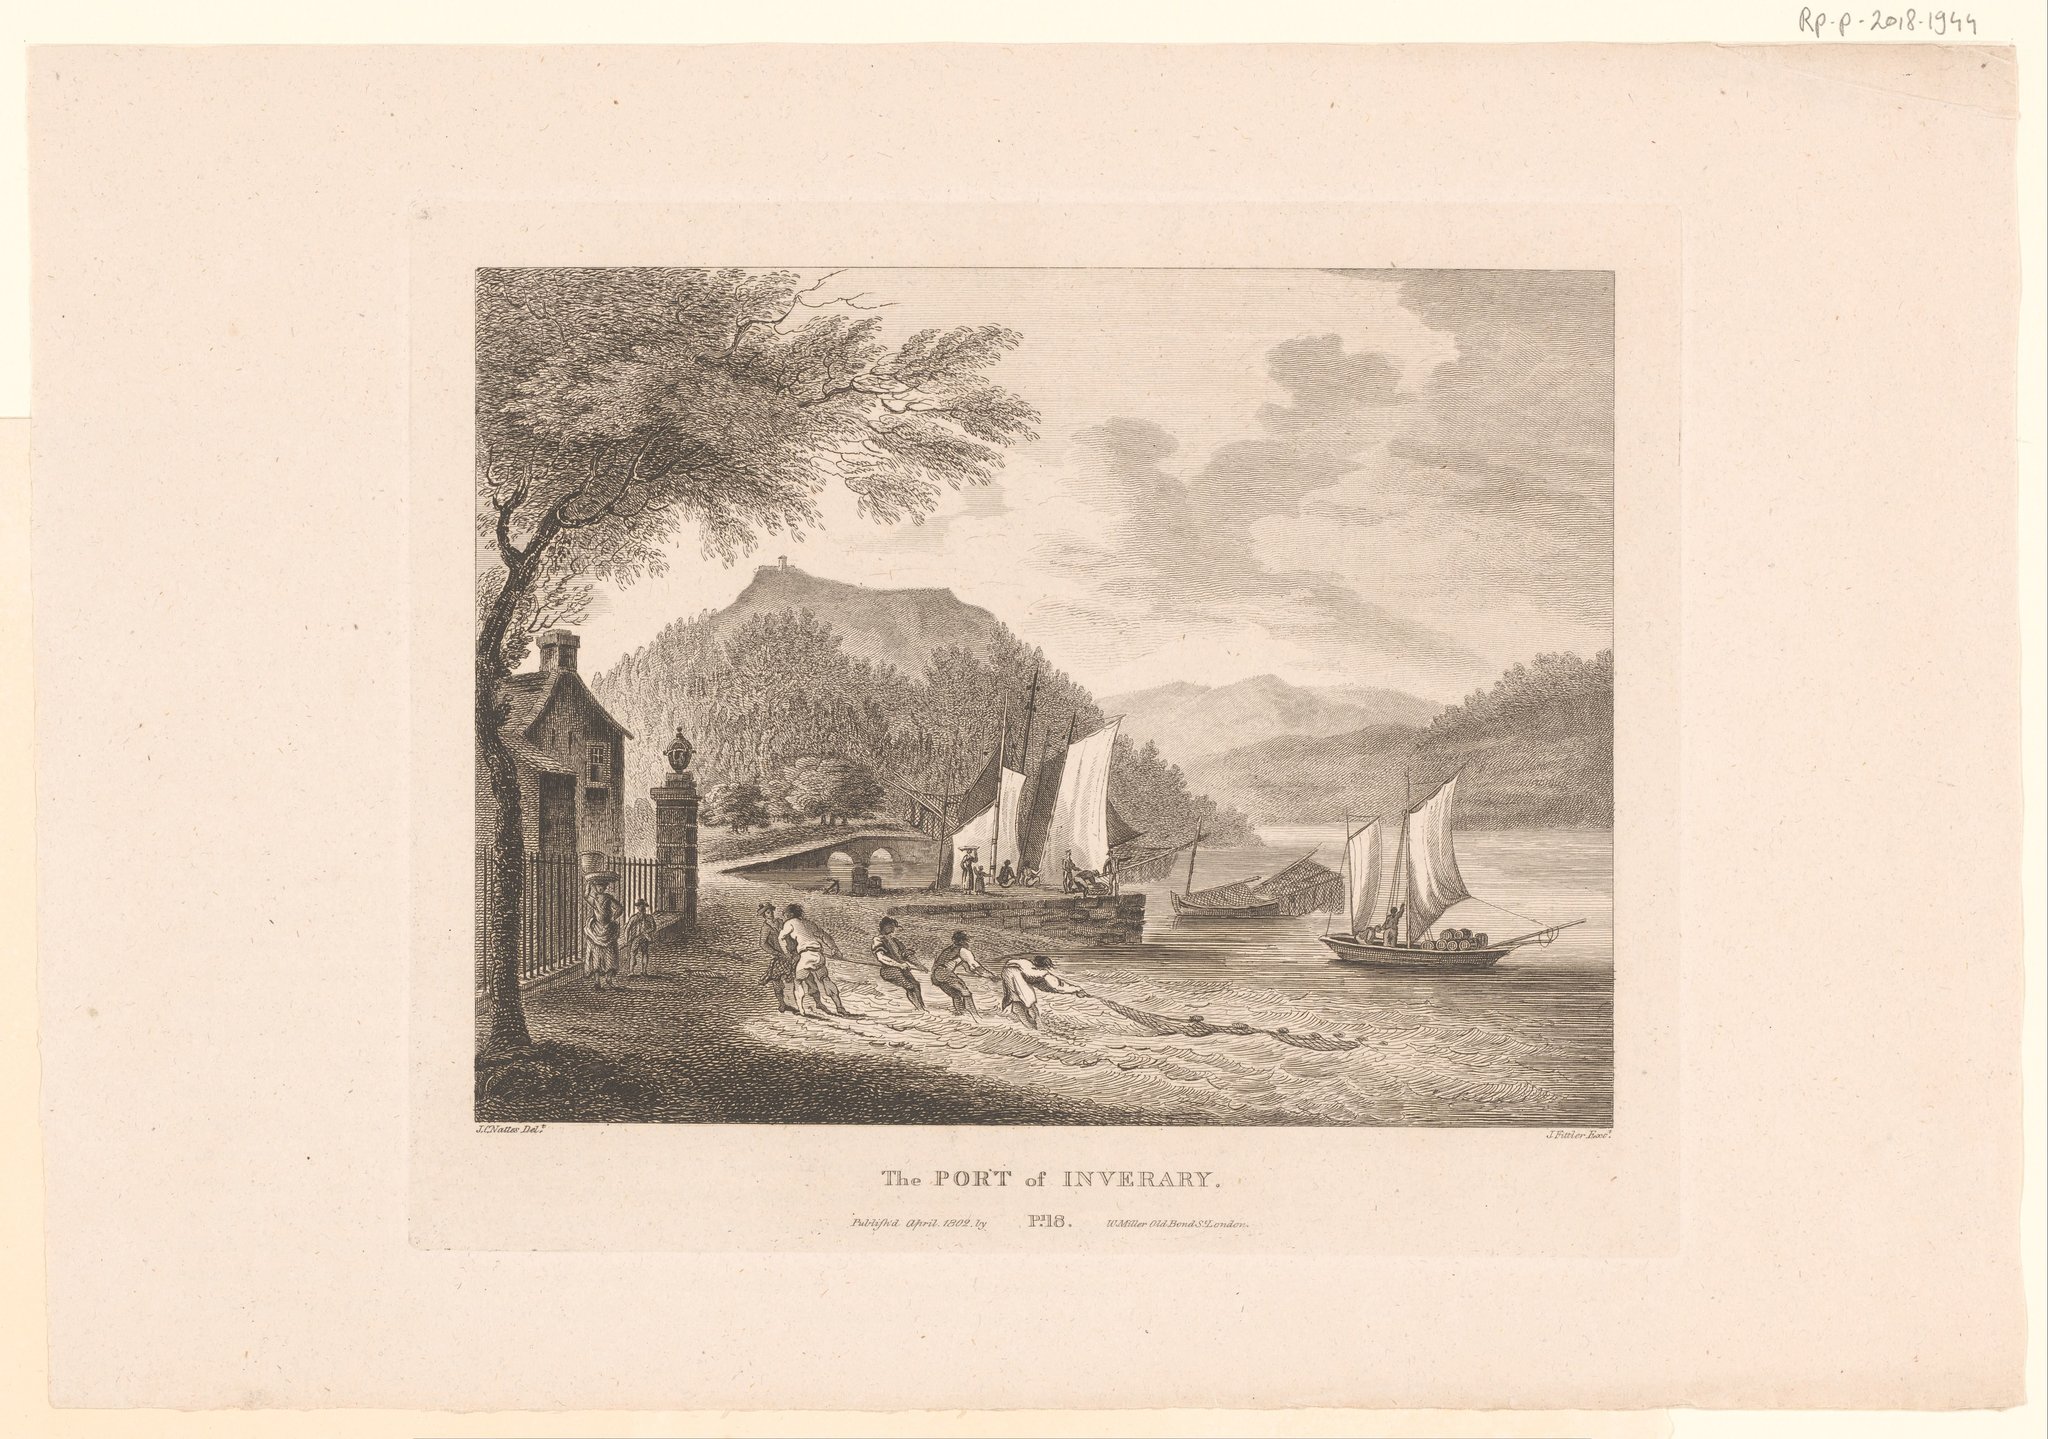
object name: print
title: The port of Inverary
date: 1801-1802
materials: paper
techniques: engraving, etching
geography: london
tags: castle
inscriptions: collector's mark: Lugt 2228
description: Prent gebruikt in: Scotia Depicta; or the antiquities, castles, public buildings, noblemen (...). Londen: William Miller, 1801. Zie ook: RP-P-2018-1945.